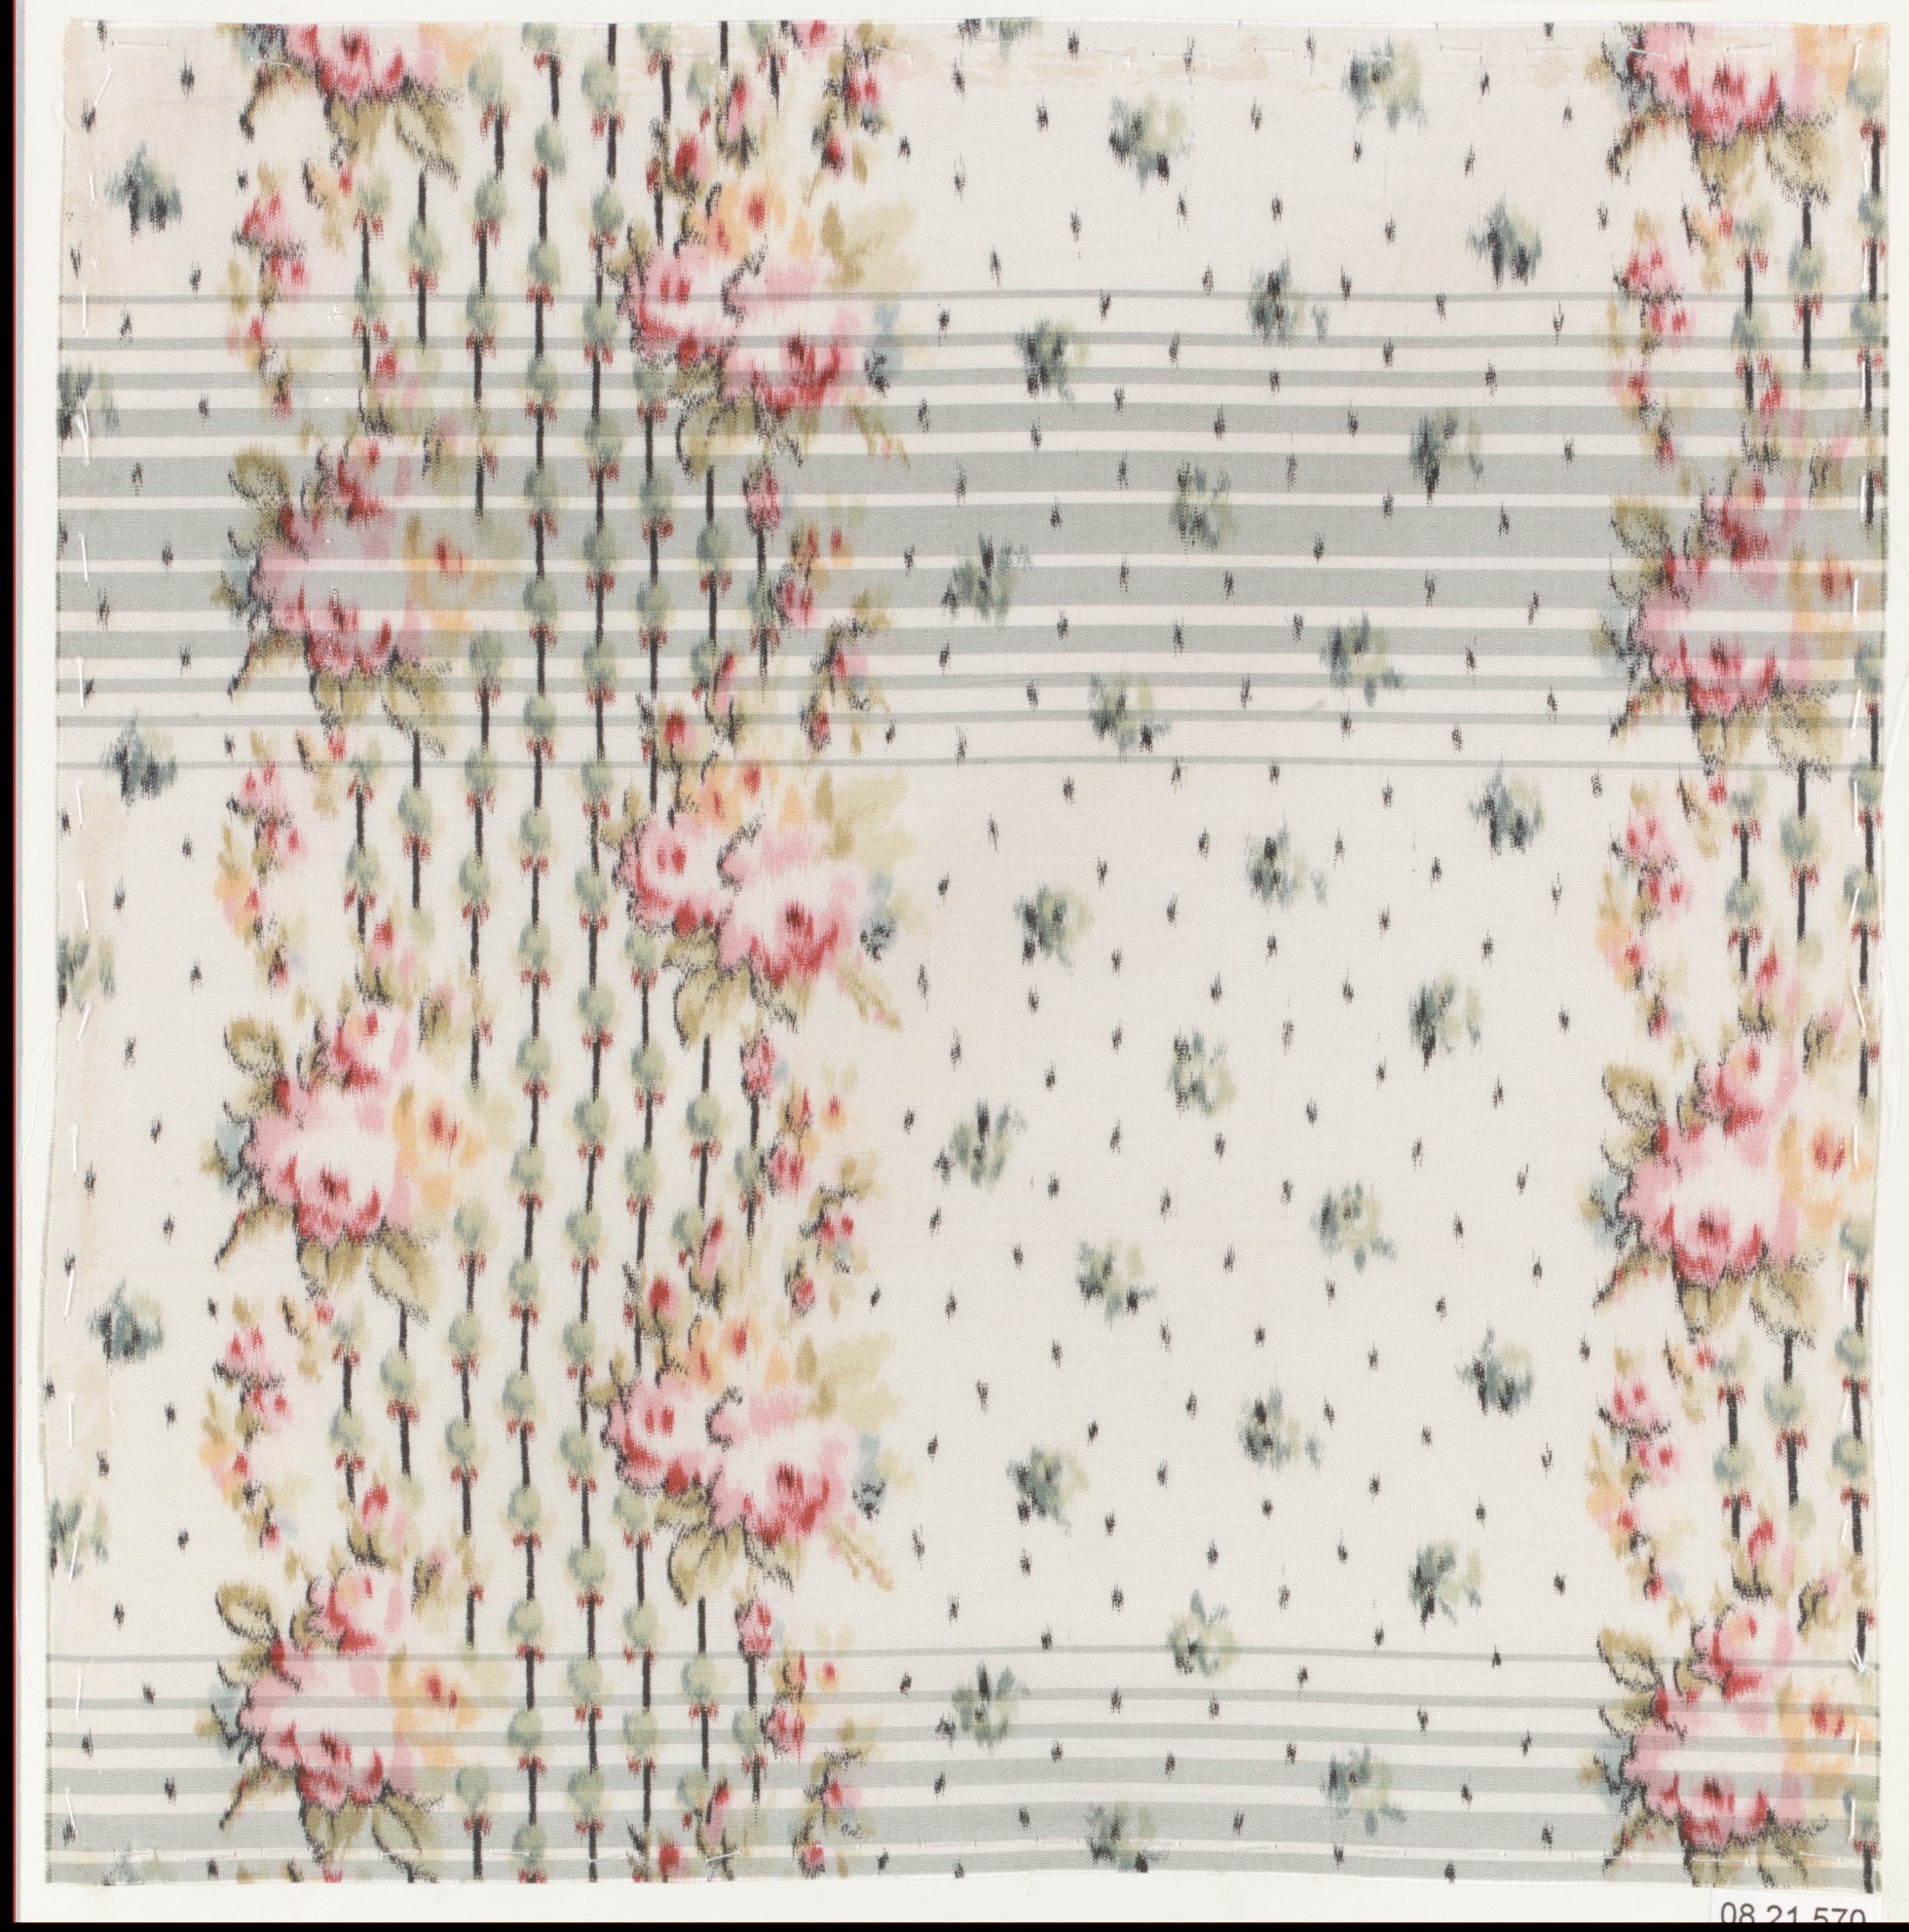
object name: textile sample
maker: Anonymous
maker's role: designer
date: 1900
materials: silk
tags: flowers